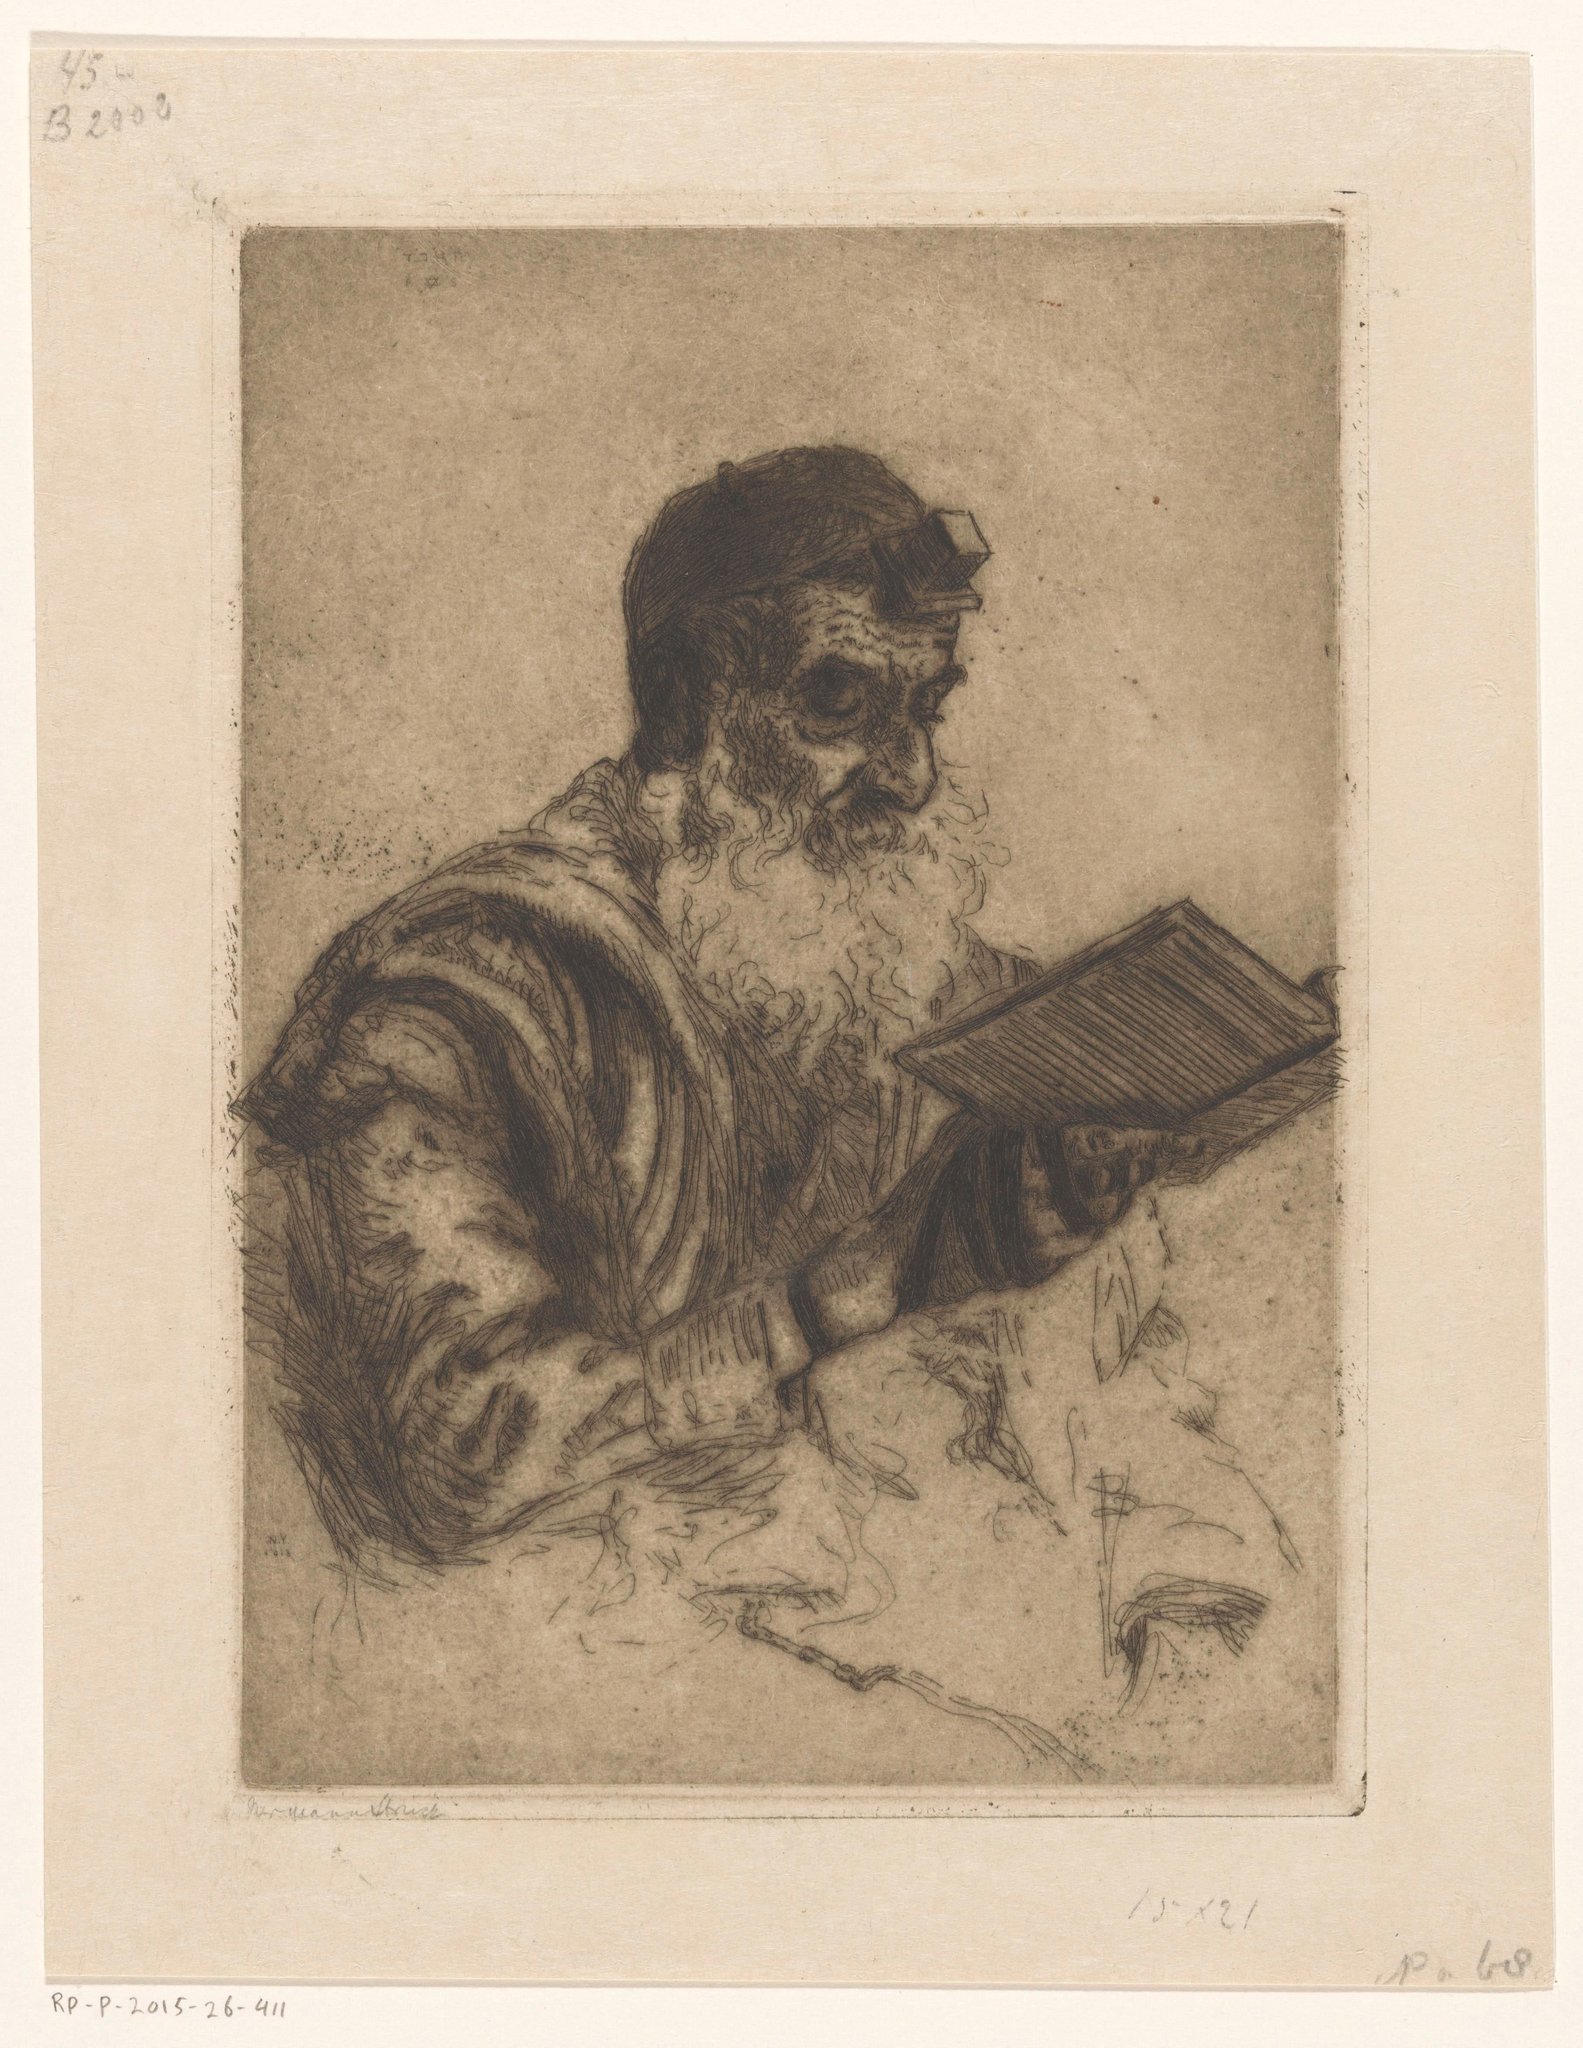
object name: print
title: Biddende joodse man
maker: hermann struck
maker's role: print maker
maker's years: 1876-1944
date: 1913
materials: paper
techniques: drypoint, etching, intaglio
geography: new york city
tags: 'tefillin', phylacteries ~ jewish ceremonial objects, 'tallit', prayer shawl worn over head and shoulders ~ jewish ceremonial objects, one person praying, the jews, jewish life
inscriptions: collector's mark: Lugt 2228, collector's mark: Lugt 4779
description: Portret van een biddende joodse man met in zijn rechterhand een gebedenboek. Hij draagt gebedsriemen, de tefilin, en een gebedskleed, de talliet.